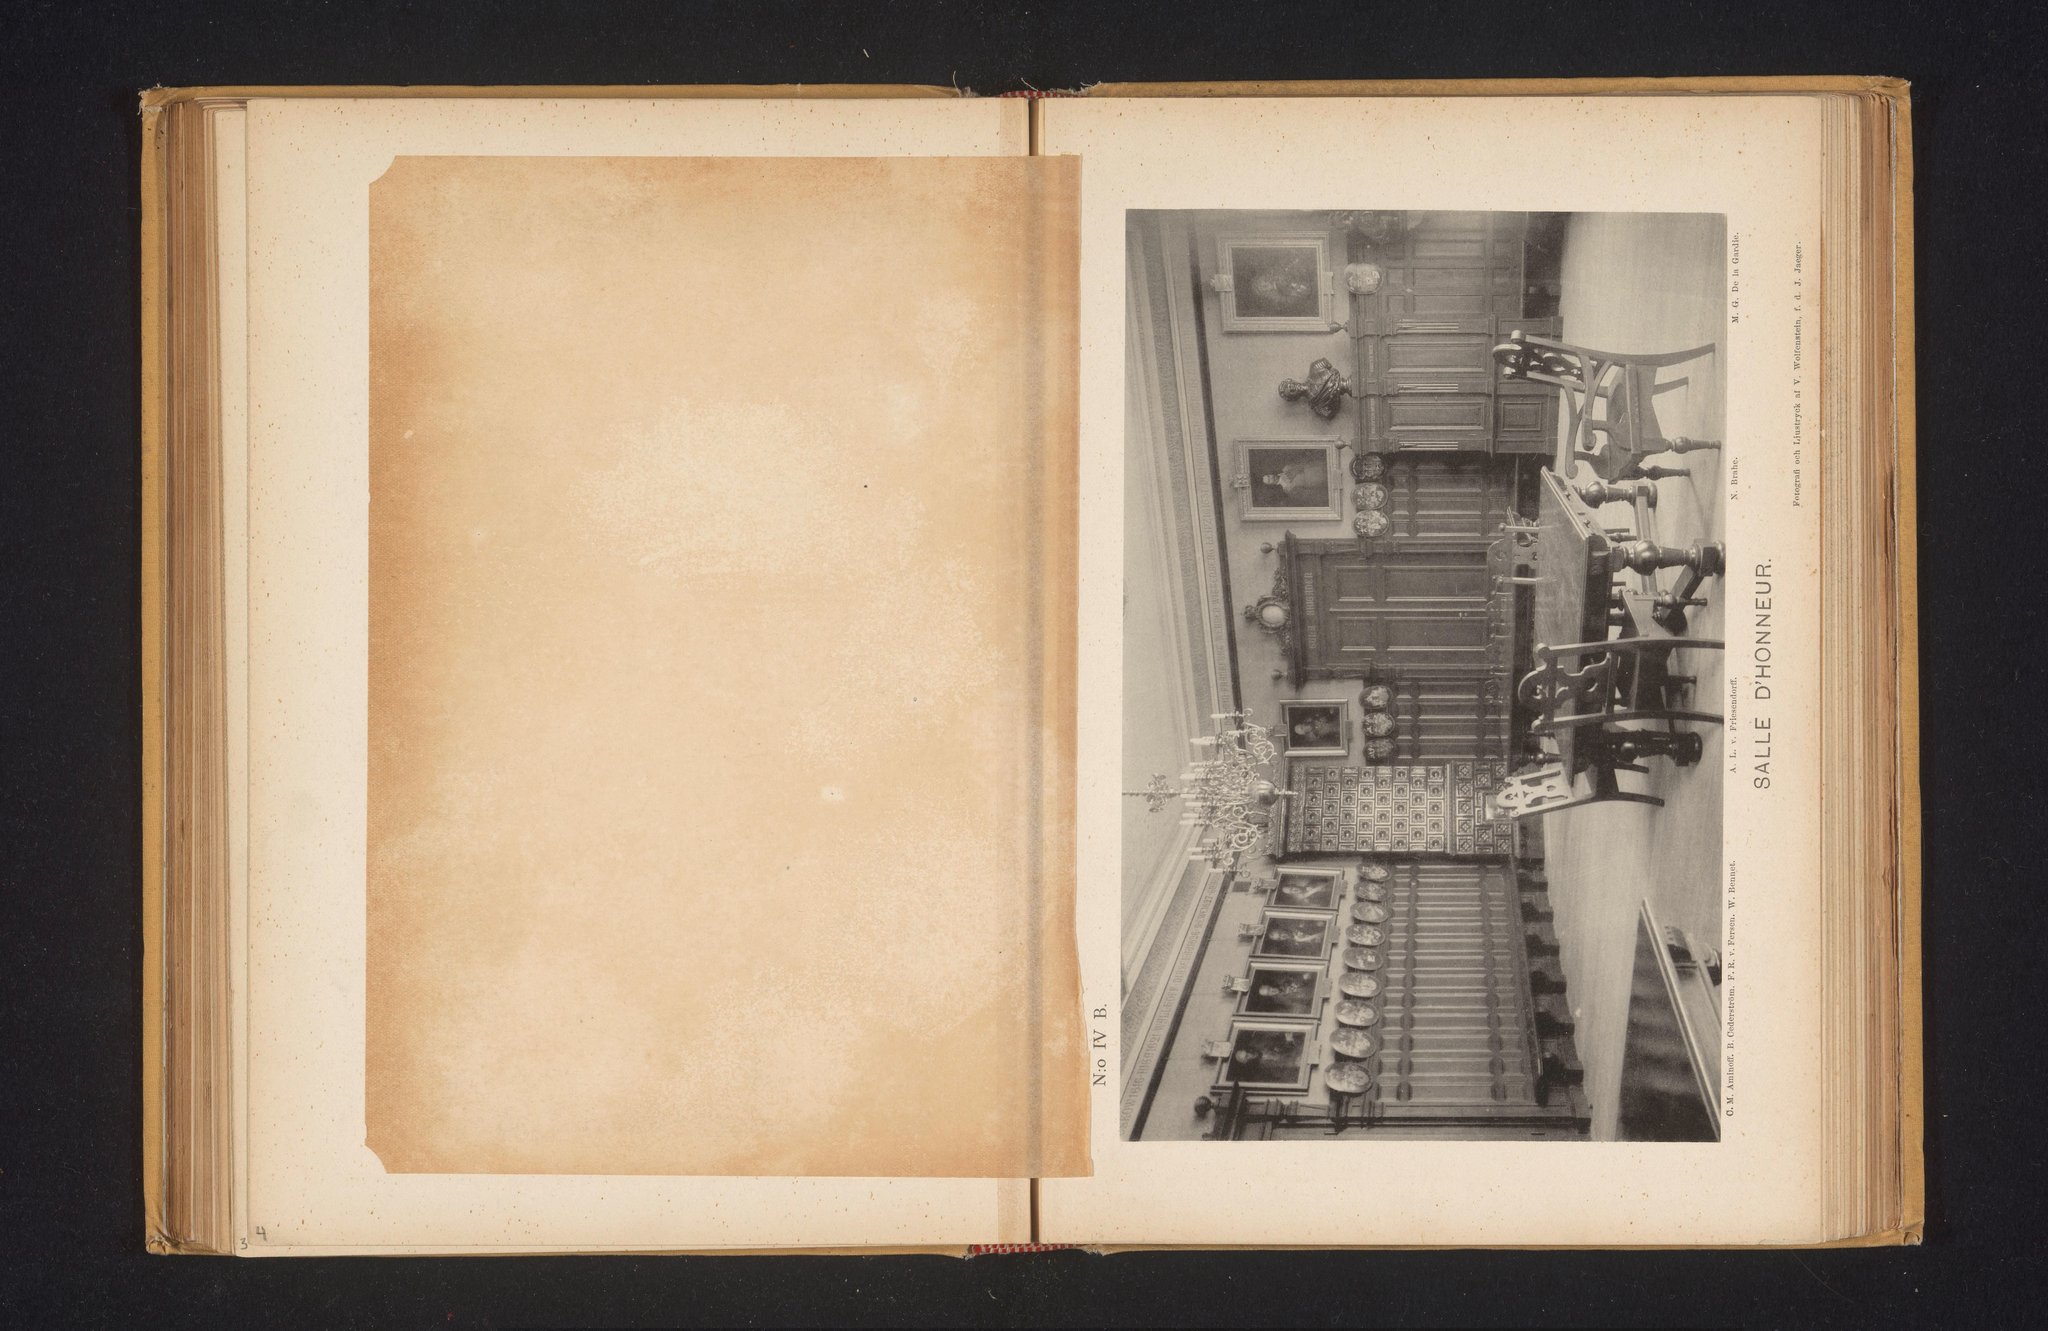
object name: page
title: Salle d'honneur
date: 1888-1891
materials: paper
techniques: photograph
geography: stockholm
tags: vestibule, hall, picture, painting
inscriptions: name: ‘C.M. Aminoff. B. Cederström. F.R. v. Fersen. W. Bennet. A.l. v. Friesendorff. N. Brahe. M.G. De la Gardie.’, number: ‘N:o IV B.’